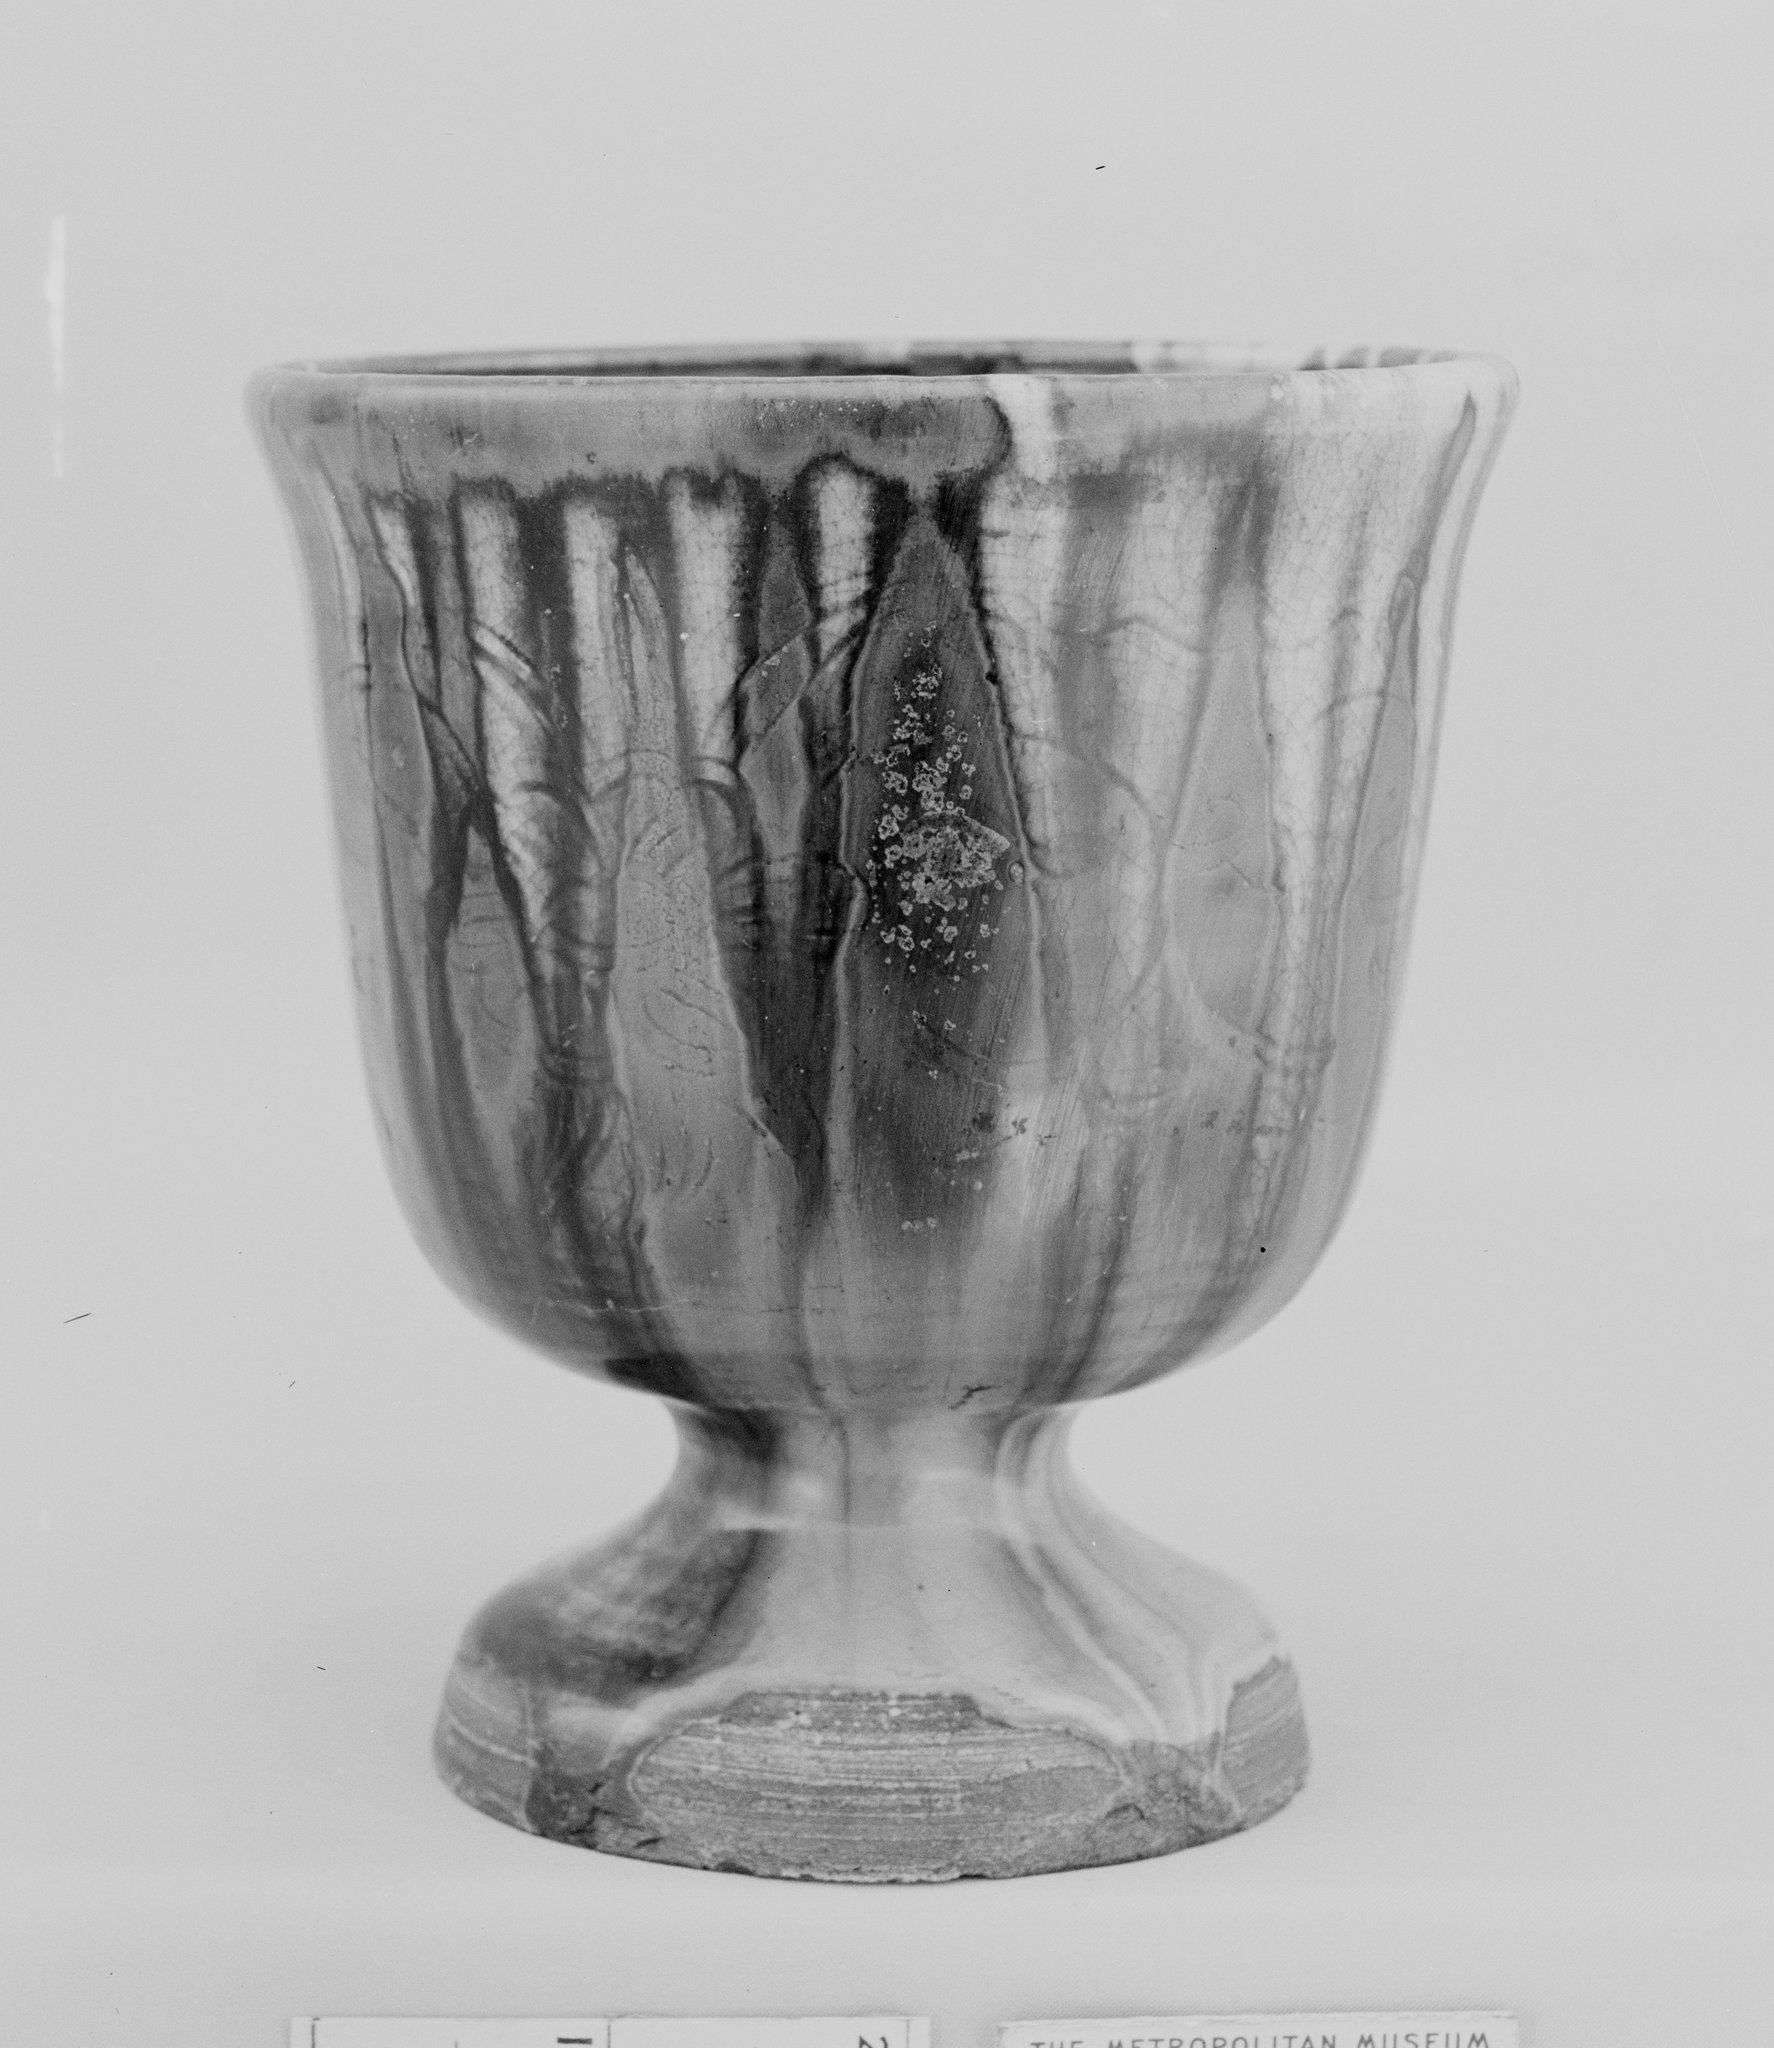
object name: cup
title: Cup on a Foot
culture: japanese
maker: shuntai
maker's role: artist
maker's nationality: japanese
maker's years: 1799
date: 1825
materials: clay, glaze